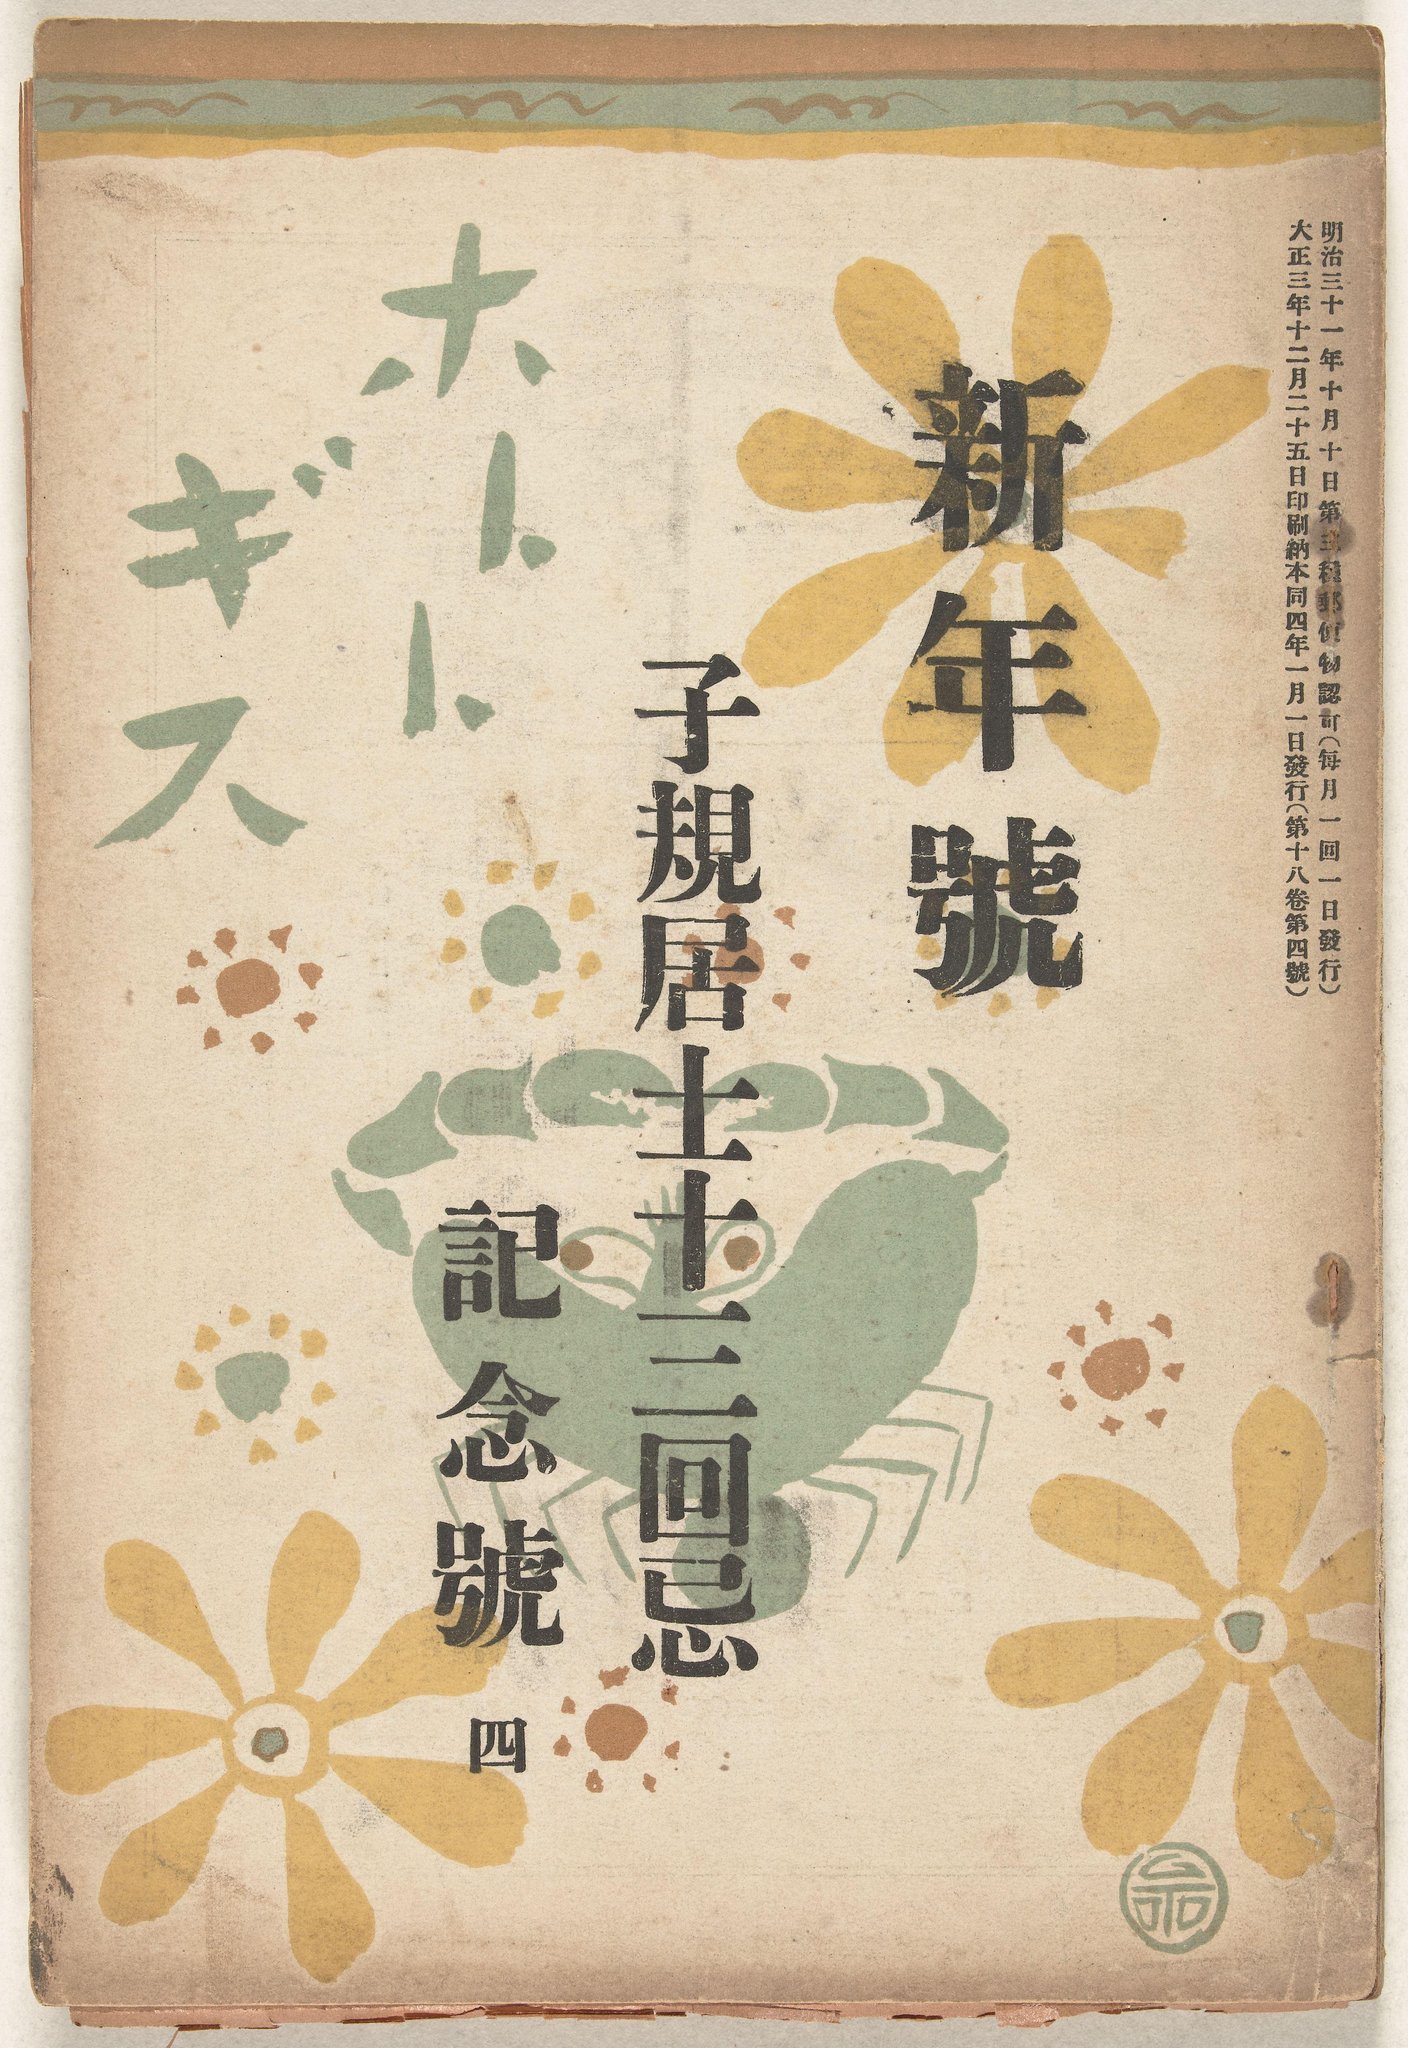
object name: book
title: December 1914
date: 1914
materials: paper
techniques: letterpress printing, lithograph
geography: japan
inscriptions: date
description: Nummer 4 van jaargang 18 (december 1914) van het literaire maandblad Hototogisu: kaft waarop gele bloemen en een groene krab; achterkant, portret van vrouw met schaal in handen en wit konijn.